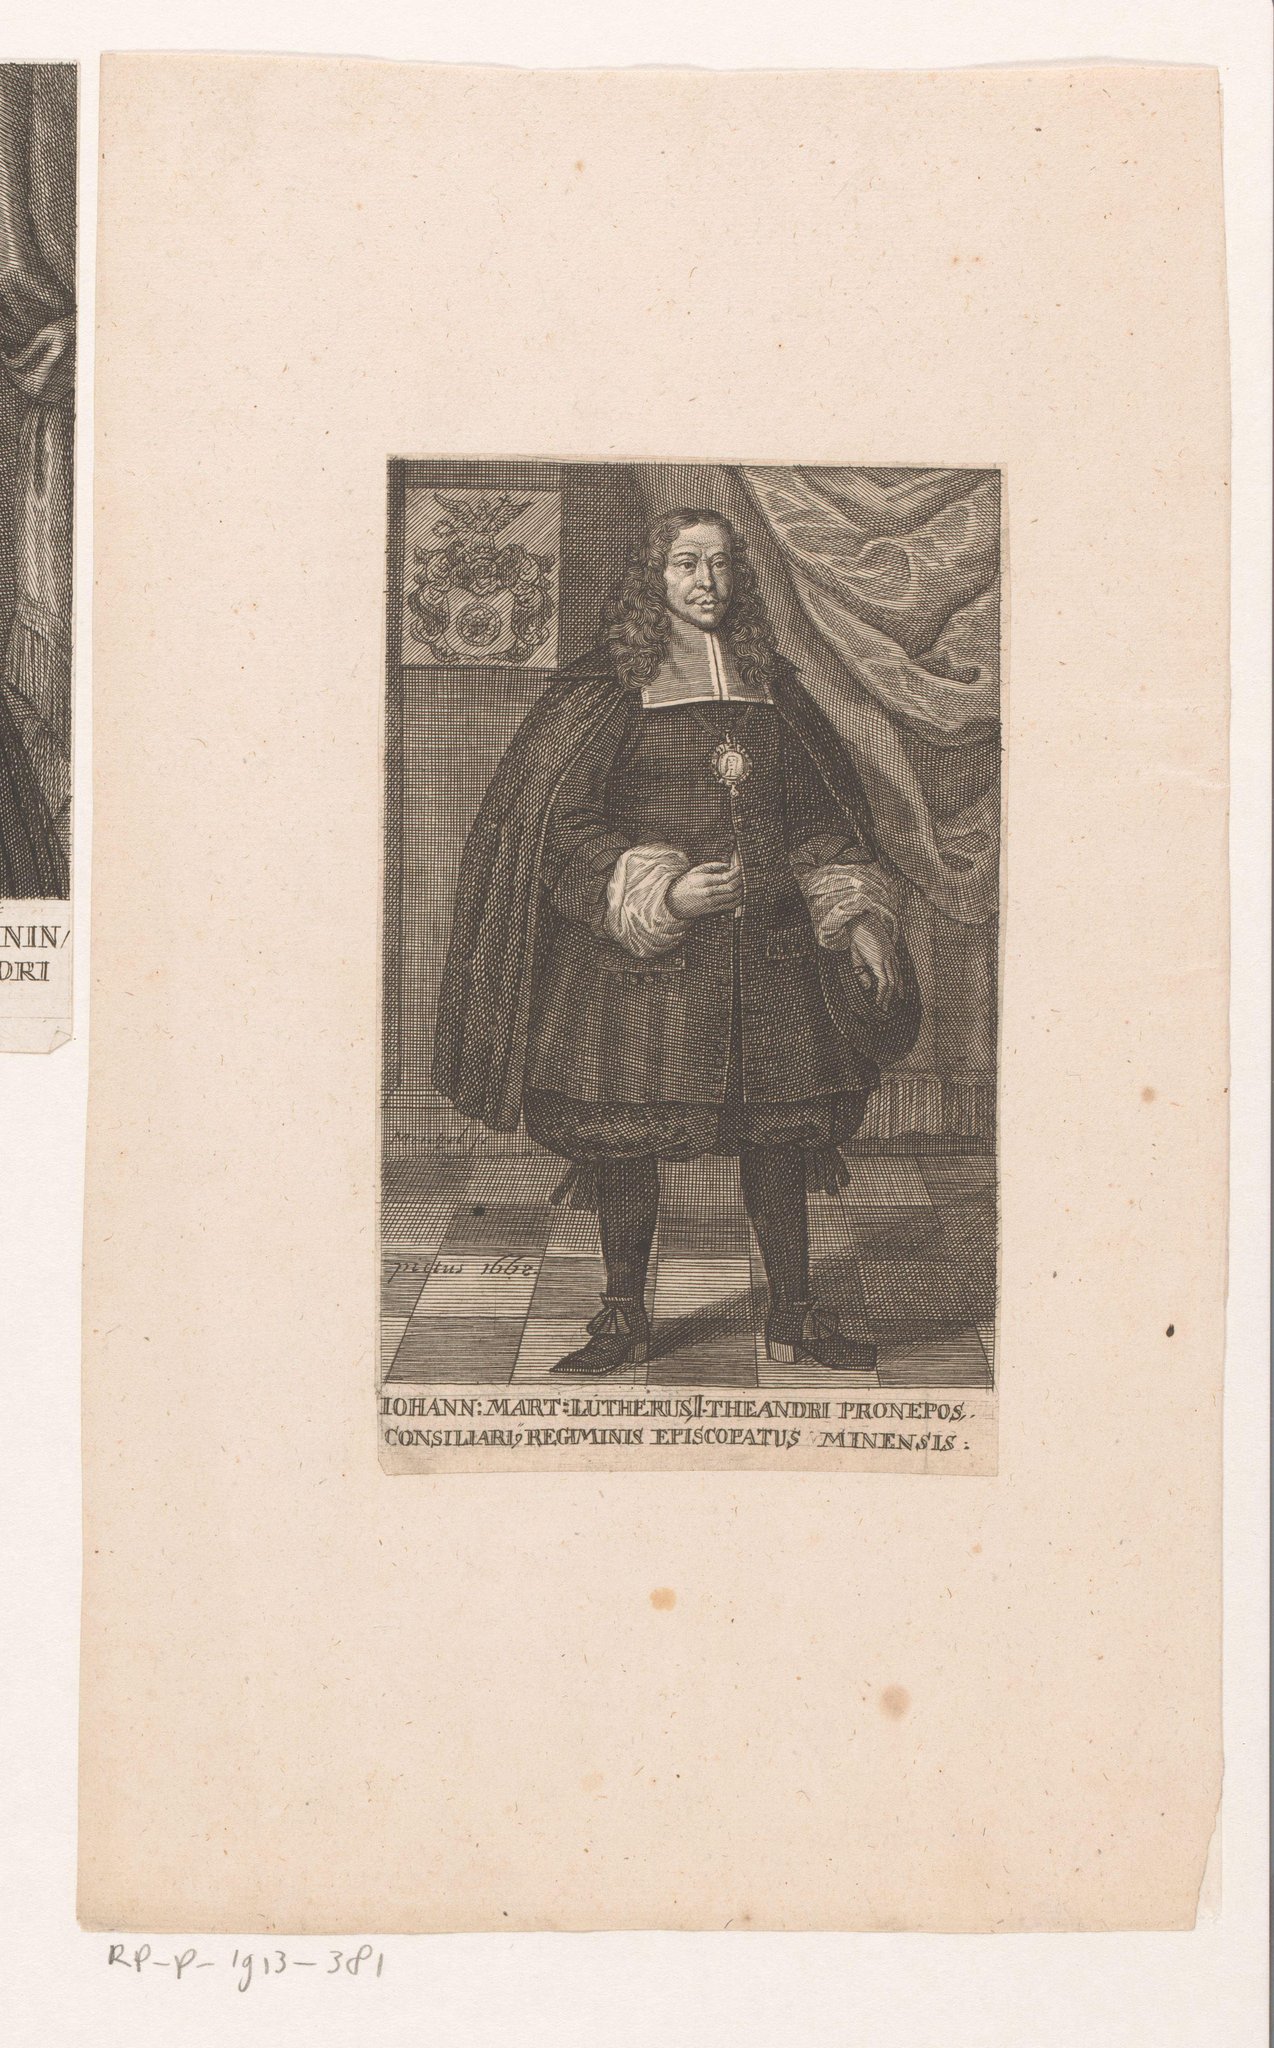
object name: print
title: Portret van Johann Martin Luther (I)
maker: johann georg mentzel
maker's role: print maker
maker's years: 1677-1743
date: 1733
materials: paper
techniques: engraving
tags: medal, badge of a guild, theologian, historical persons, armorial bearing, heraldry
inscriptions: collector's mark: Lugt 2228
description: Prent ook gebruikt in: Richter, David. Genealogia Lutherorum (...). Berlin/Leipzig: Johann Andreas Rüdiger, 1733.